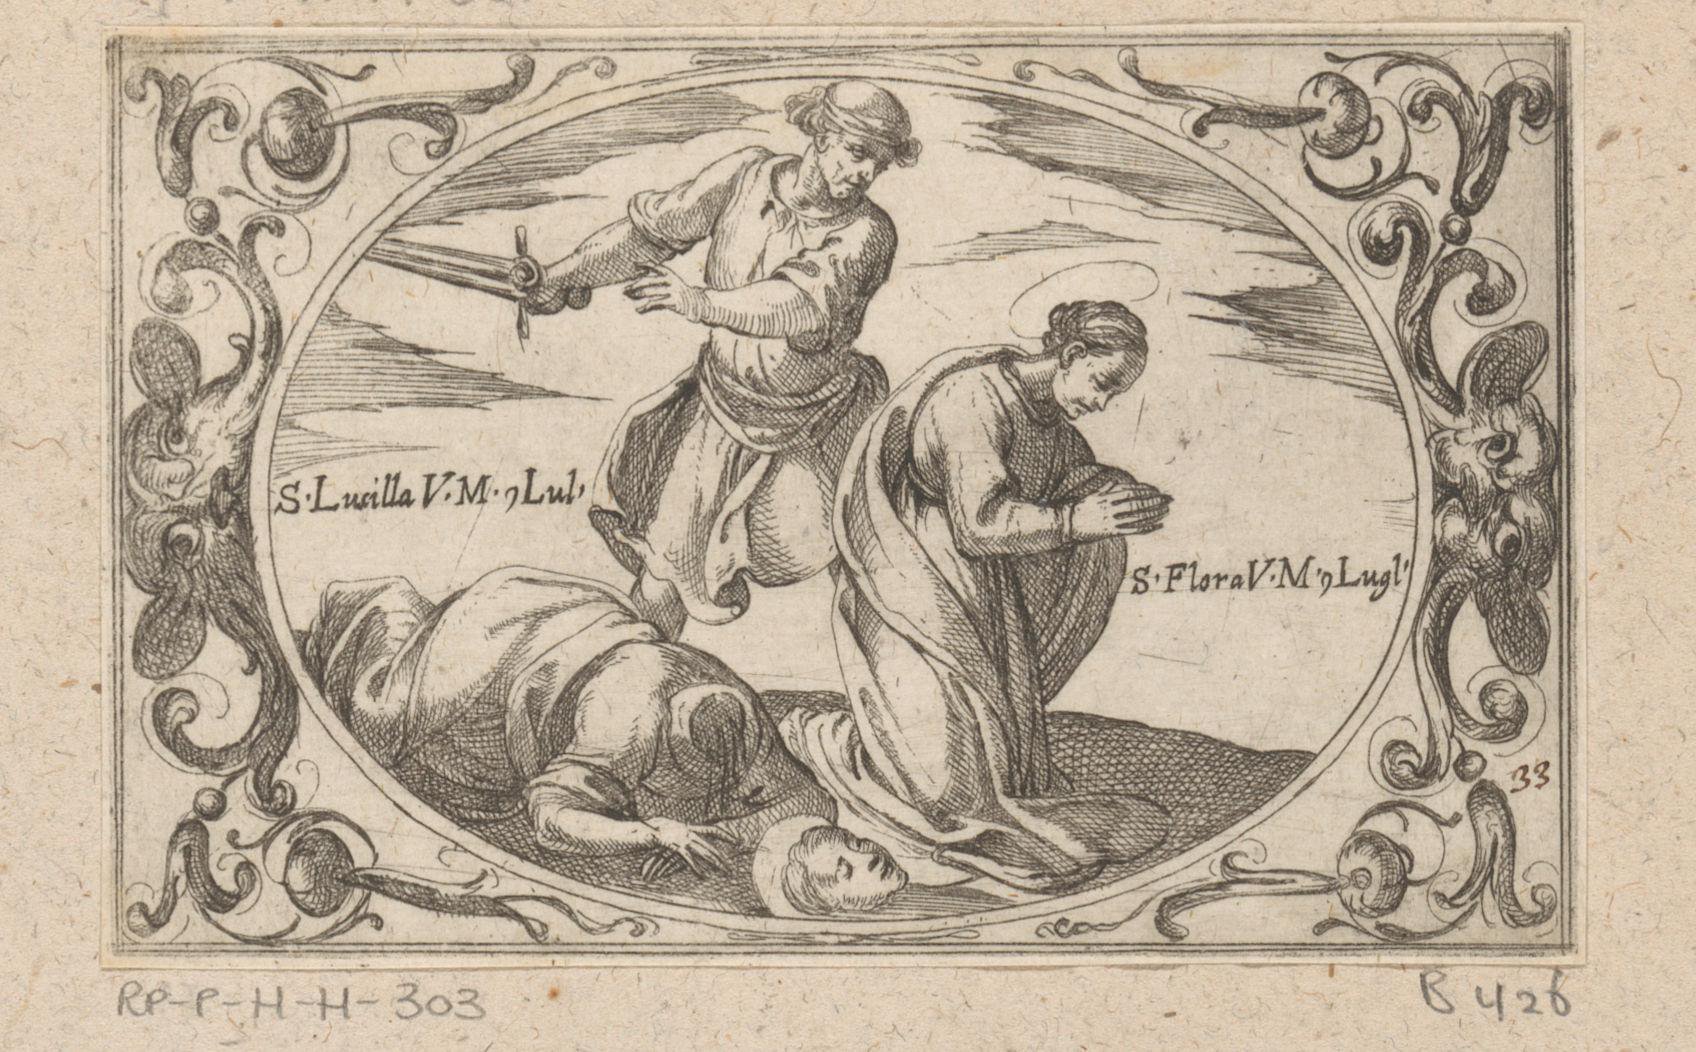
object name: print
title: Imagini di moltes vergini Rom nel martirio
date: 1565-1630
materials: paper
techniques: etching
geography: rome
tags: martyr(s) (often with palm-branches) - qq - female martyr, violent death by beheading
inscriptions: number: ‘33’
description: Deze prent maakt deel uit van een reeks van 73 prenten (+ titelprent) met voorstellingen van Romeinse martelaressen.